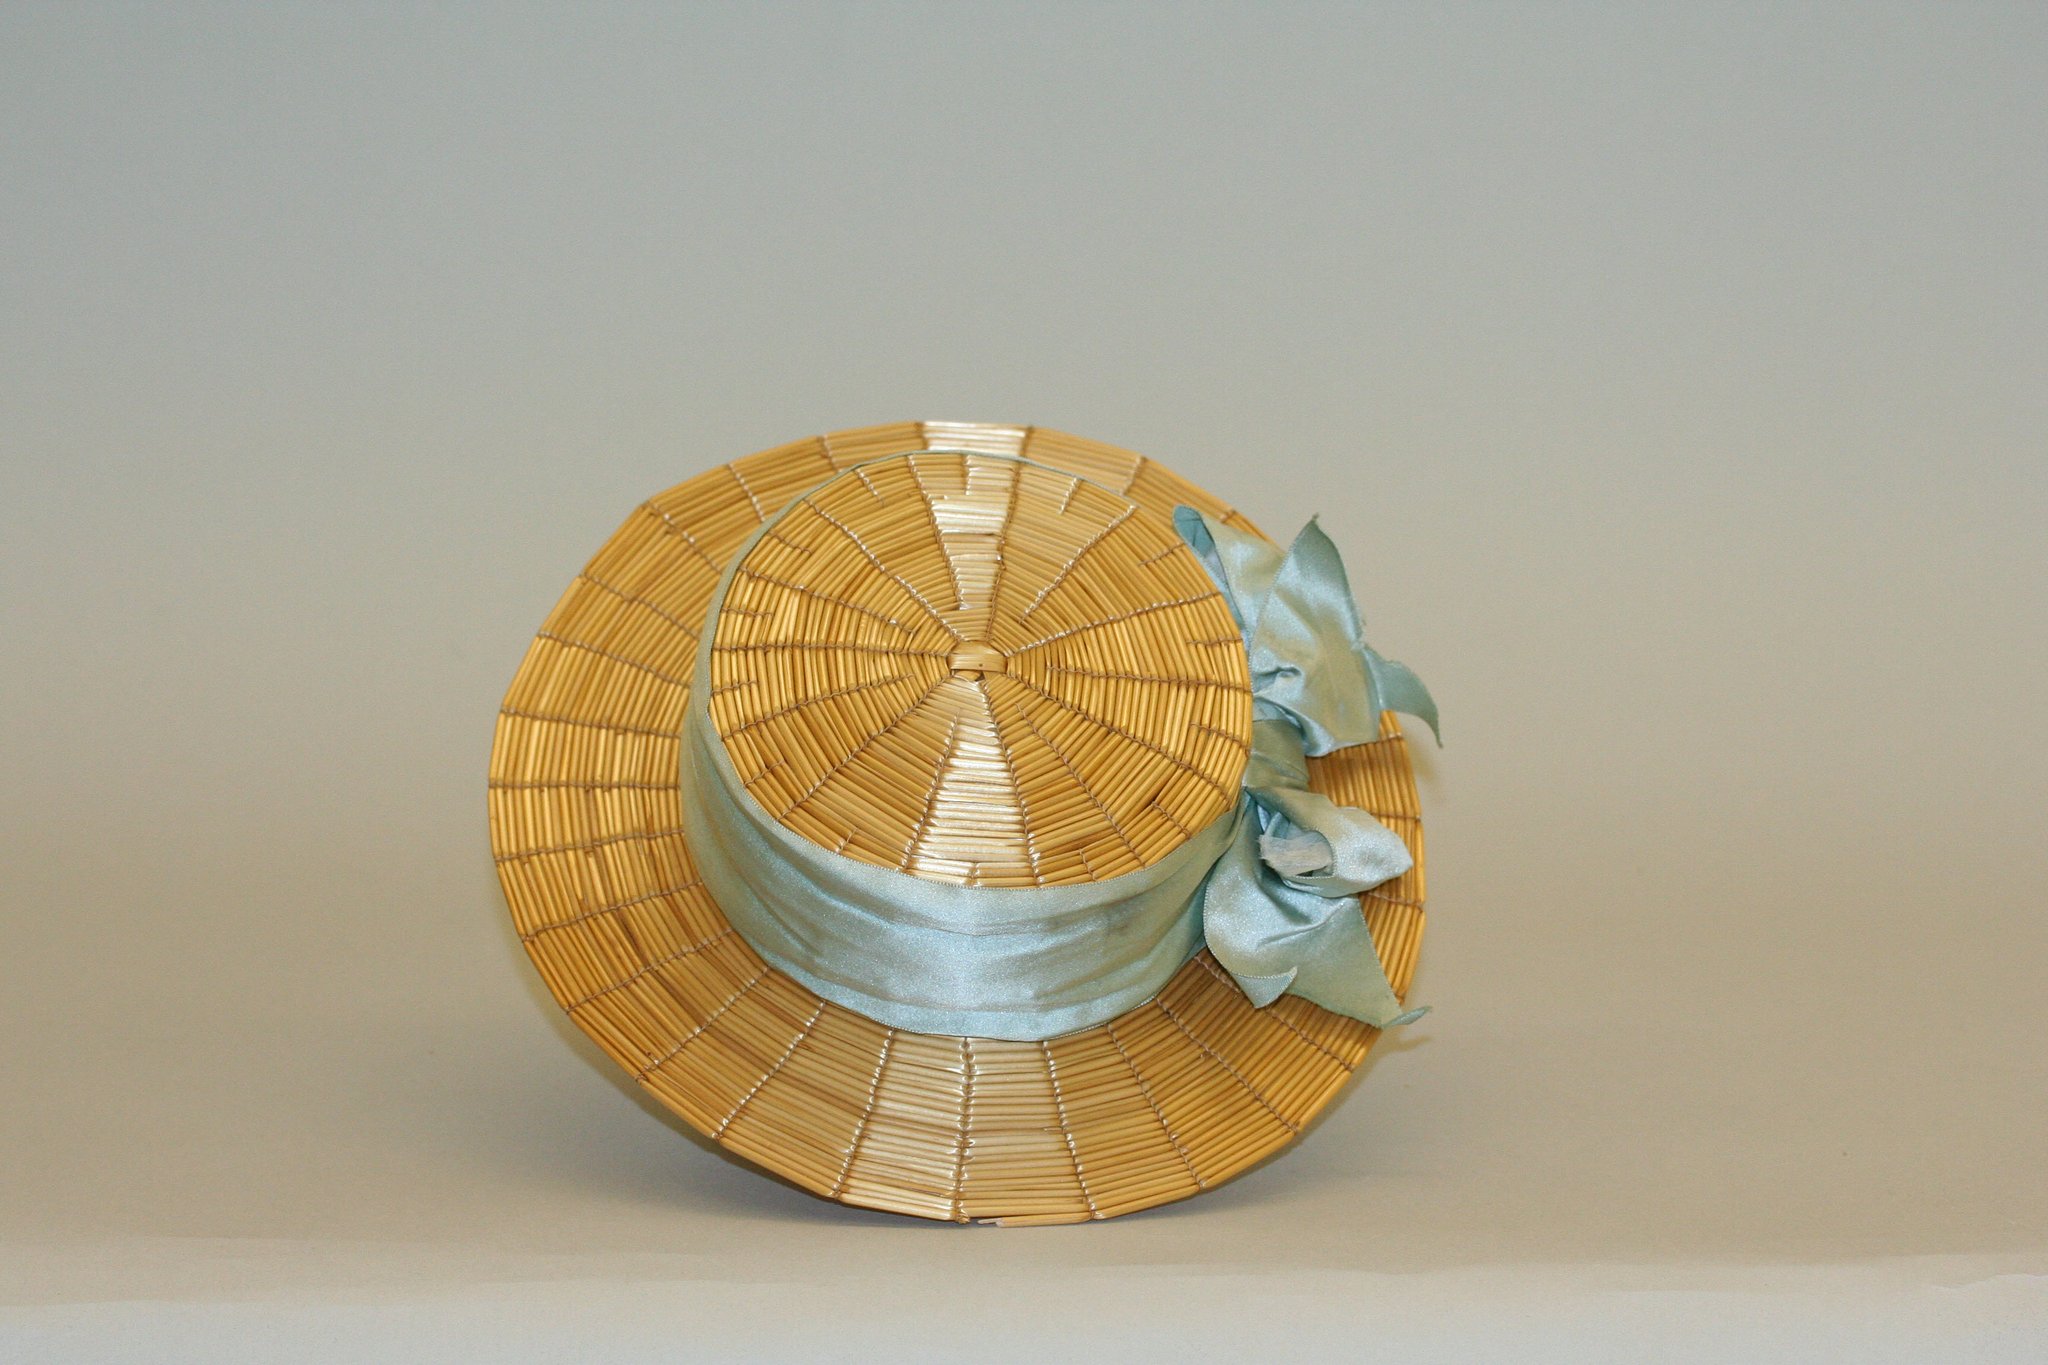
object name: hat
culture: american or european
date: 1867-1900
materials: fiber